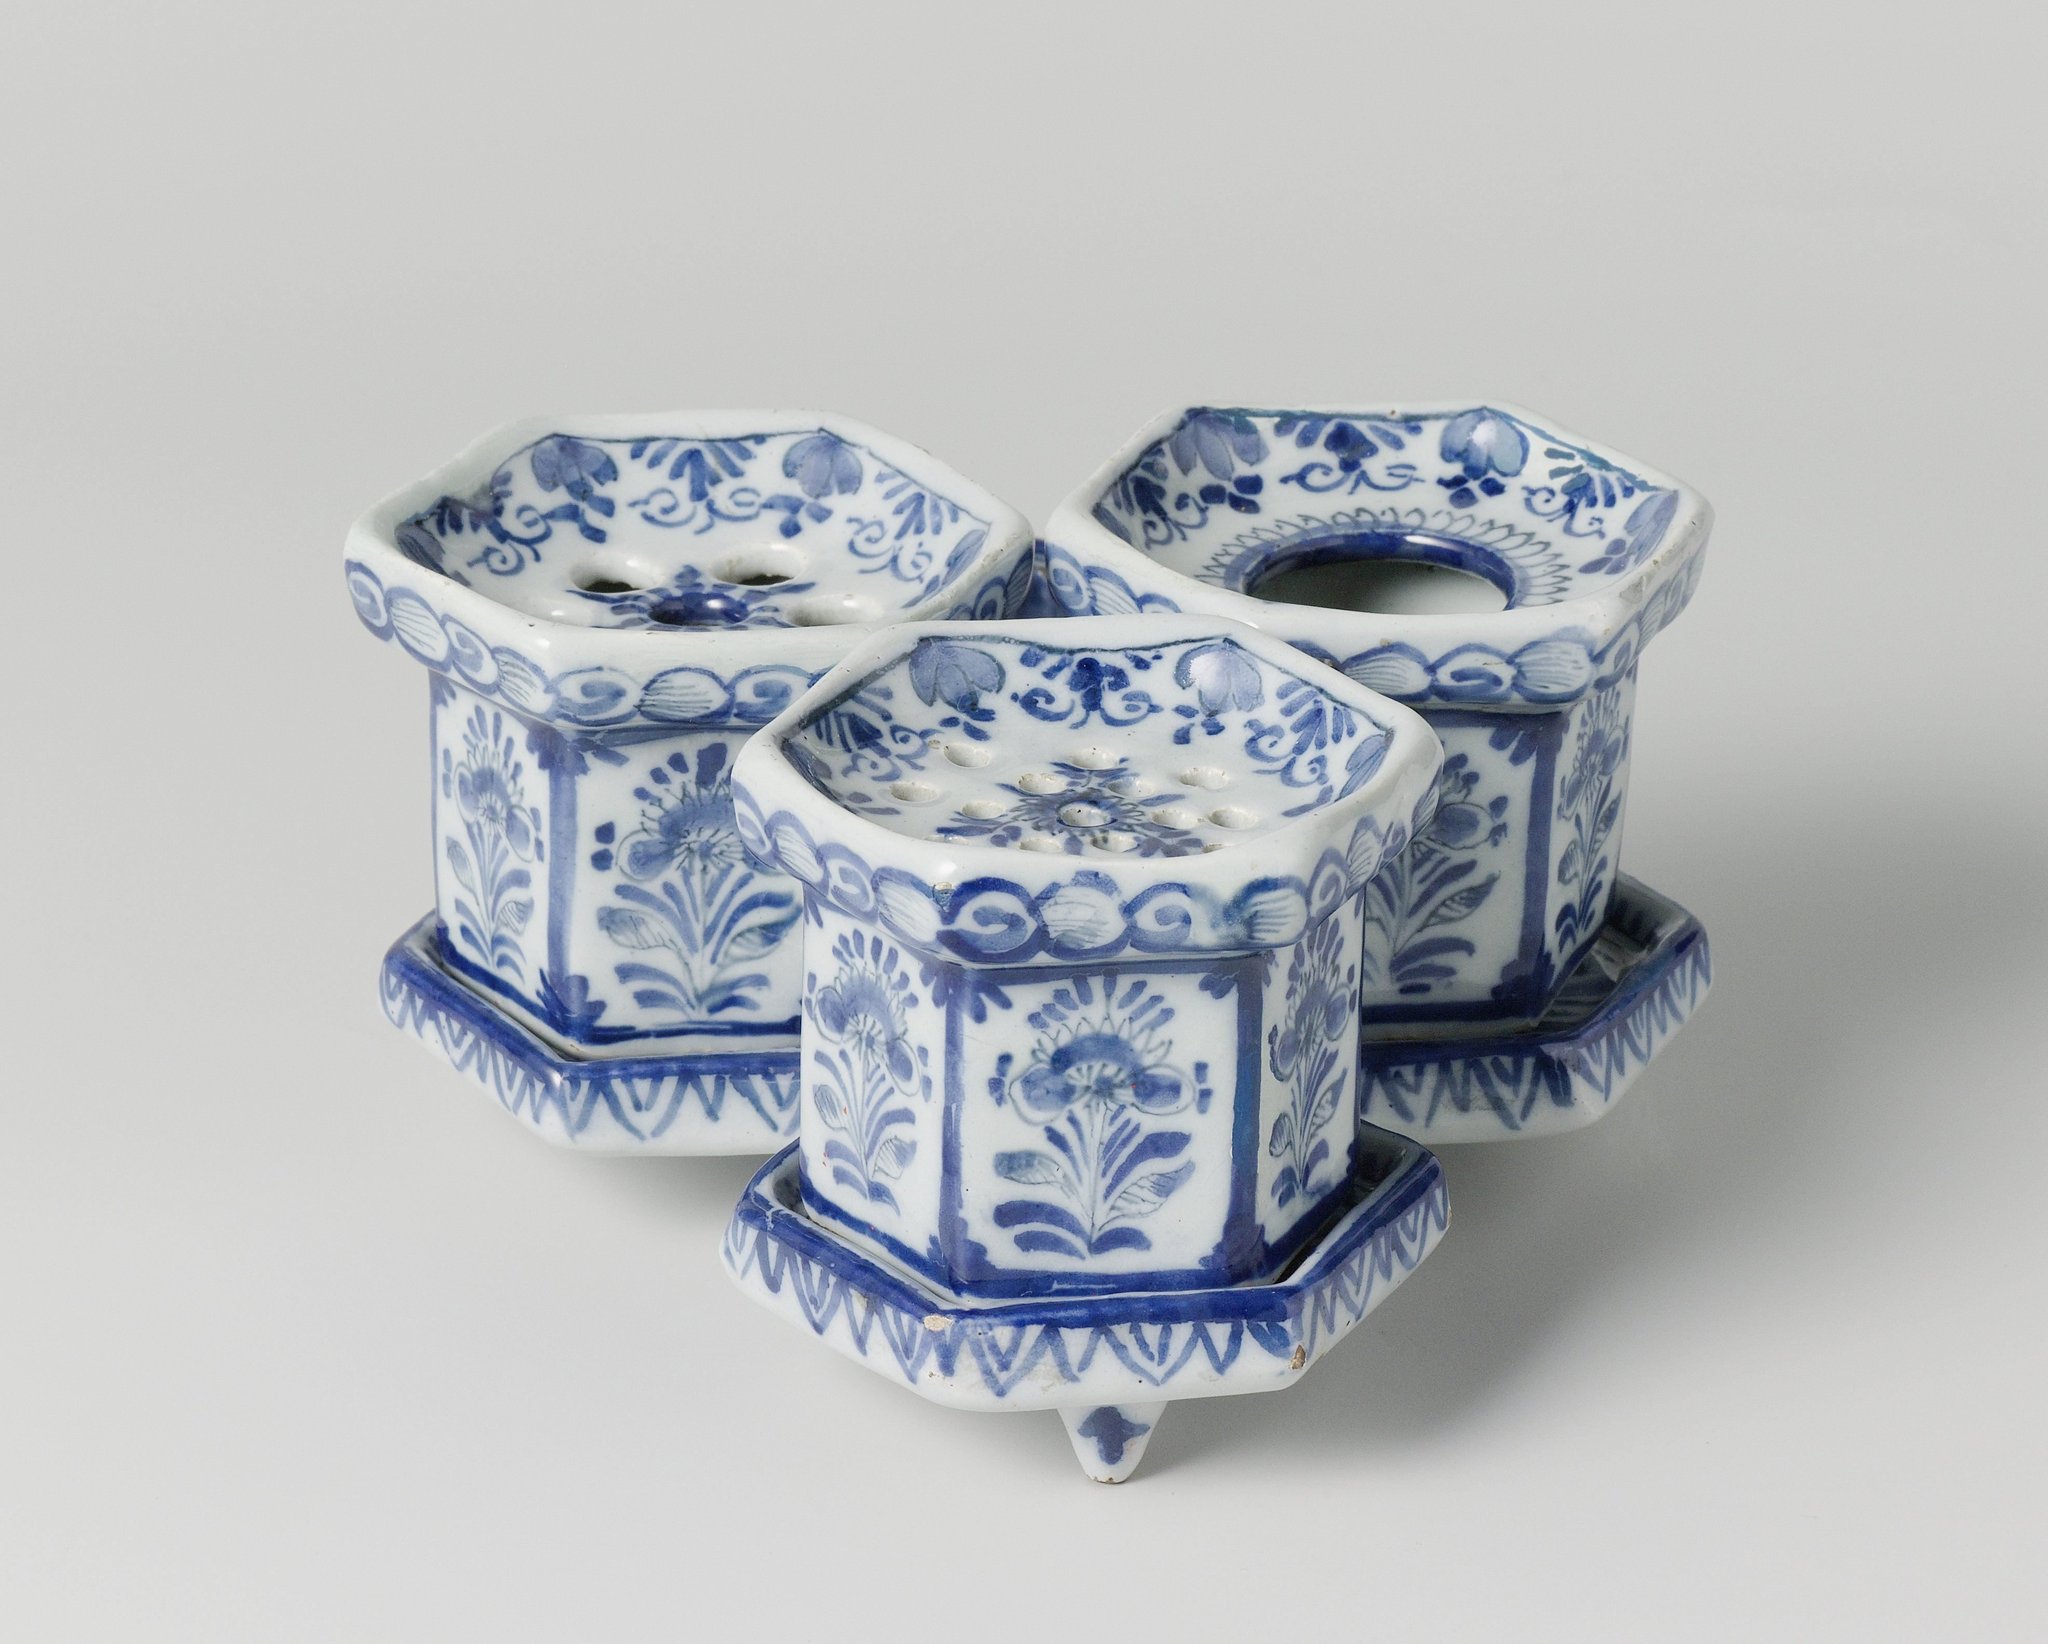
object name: inkstand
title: Inktstel van faience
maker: johannes van duijn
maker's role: plateelbakker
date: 1760-1780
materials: faience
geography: delft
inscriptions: mark: ‘IVD(ineen)uijn’, mark: ‘[....] figuratieve slinger’, mark: ‘IVD(ineen)uijn’, mark: ‘[...]Duijn’